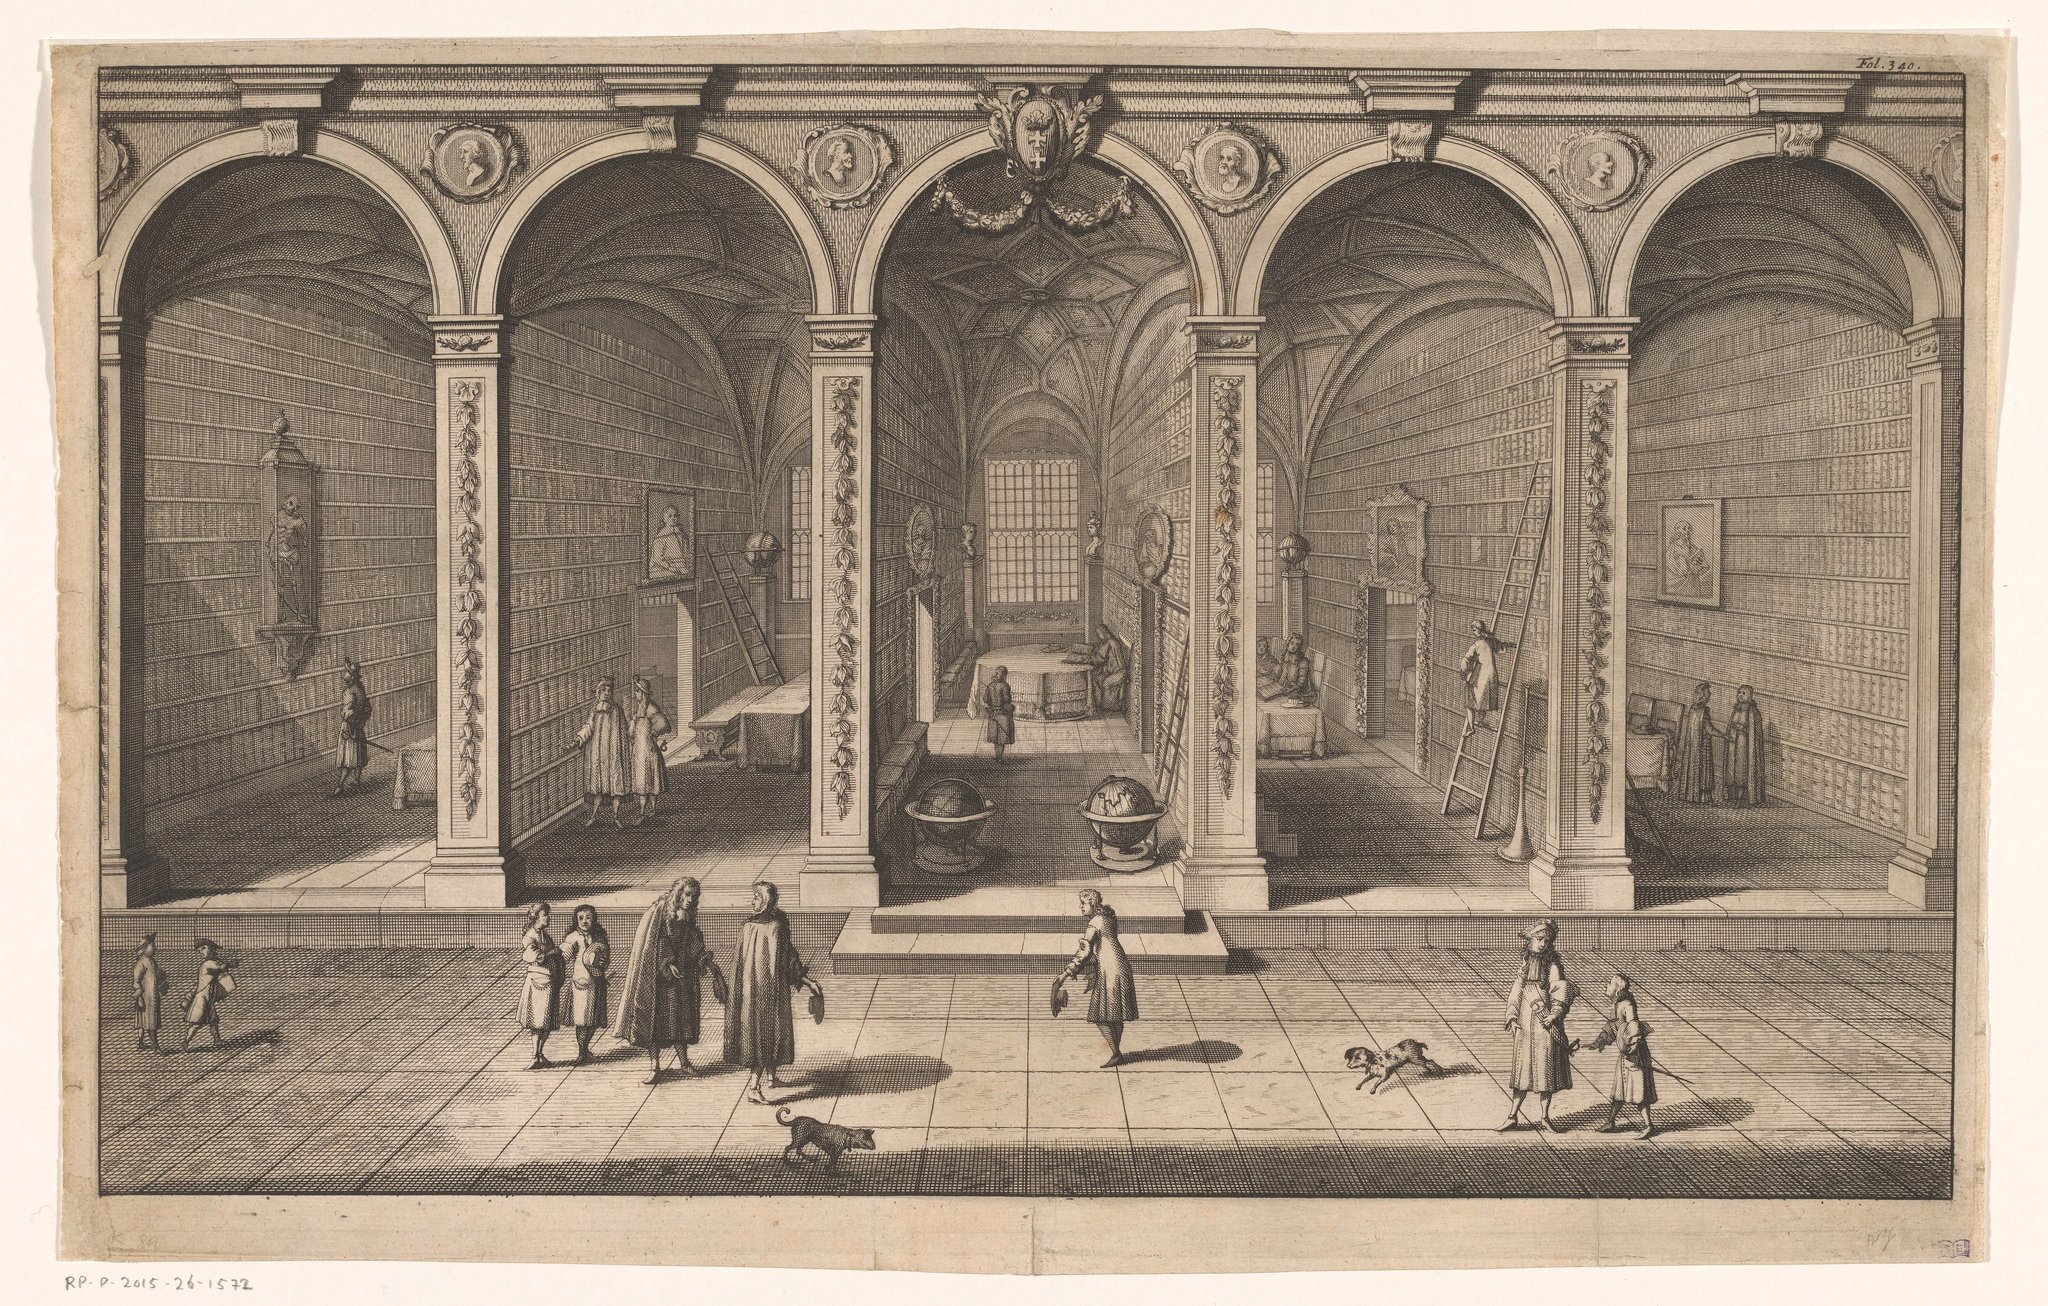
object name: print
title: Interieur van de stadsbibliotheek te Gdansk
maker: Anonymous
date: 1687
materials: paper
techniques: engraving, etching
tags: writing-table, writing-desk, (human) skeleton, globe, public library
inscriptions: collector's mark: Lugt 4780, collector's mark: Lugt 4779, collector's mark: Lugt 2228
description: Gezicht op een binnenplaats met een opengewerkte façade versierd met portretmedaillons met in het midden het wapen van Gdansk. De ruimte achter de facade is verdeeld in vijf met boeken gevulde vertrekken. In de linker kijkt een man naar een skelet met een zeis in een vitrine. In het middelste vertrek een man achter een leestafel met op de voorgrond twee wereldbollen. Op de binnenplaats mannen, kinderen en twee honden. Rechtsboven genummerd: Fol. 340.